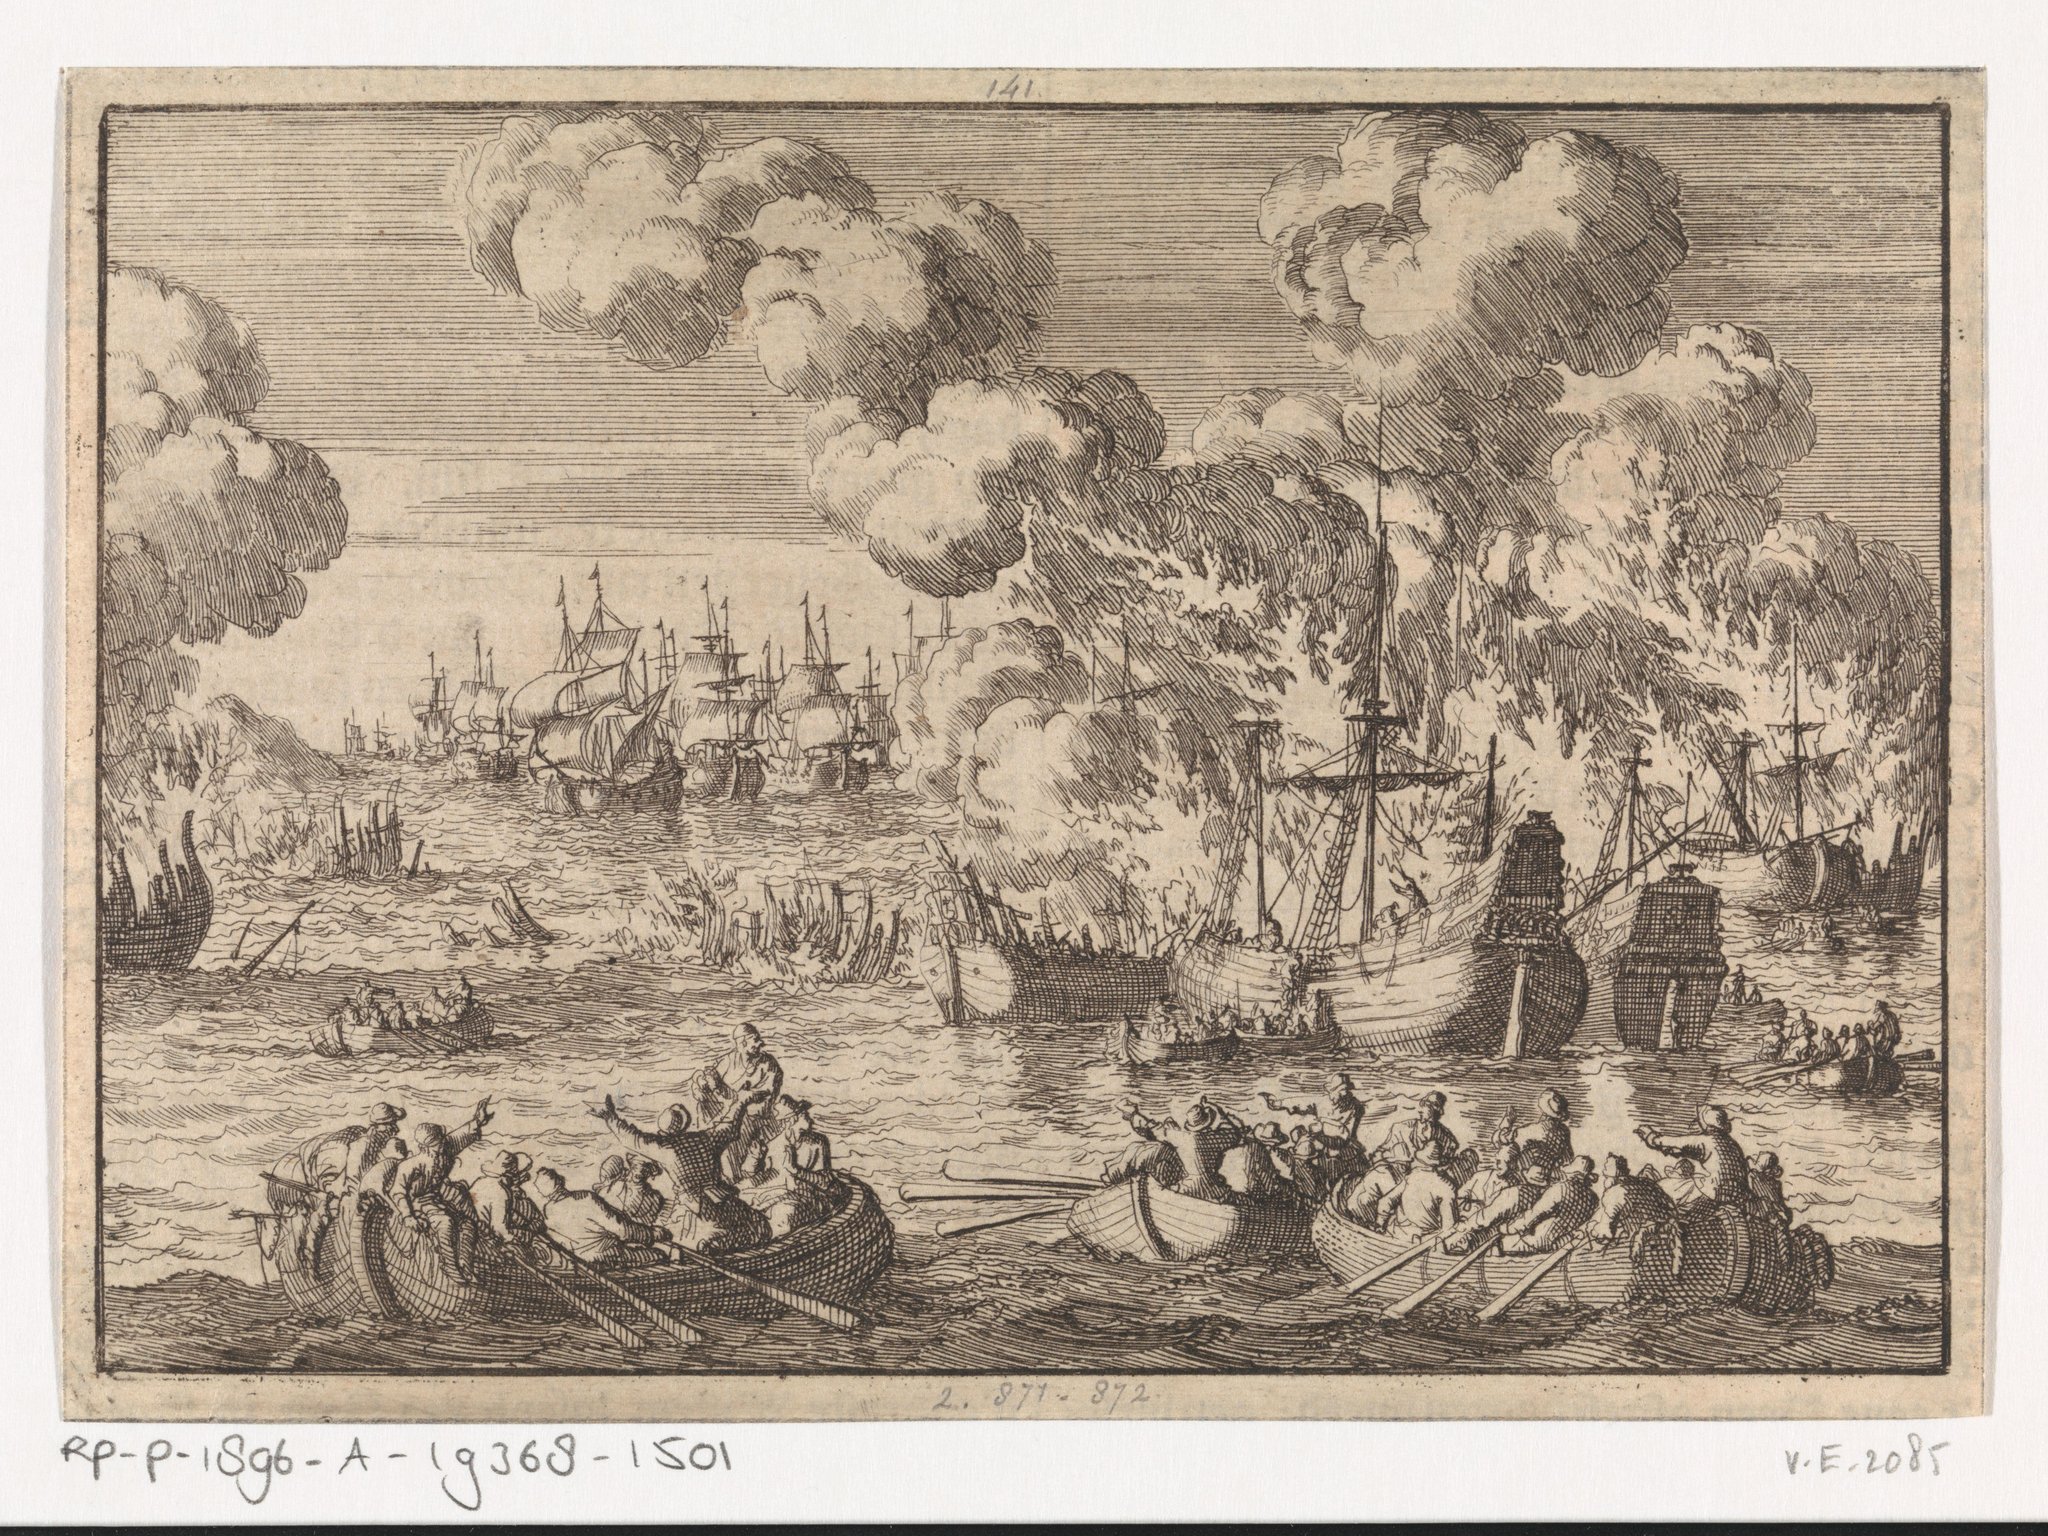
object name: book illustration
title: Hollandse koopvaardijvloot wordt in het Vlie door Engelse branders vernietigd, 1666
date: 1698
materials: paper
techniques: etching, letterpress printing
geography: leiden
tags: surprise attack (stratagem) (+ naval force), battle (+ naval force)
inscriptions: collector's mark: Lugt 2228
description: Illustratie uit: Gottfried, Johann Ludwig. Historische kronyck; vervattende een (...) beschrijvingh der aldergedenckwaerdigste geschiedenissen des weerelds, van den aenvangh der scheppingh tot (...) 1576 (2 delen). Leiden: Pieter van der Aa, 1698, dl. II, p. 871.